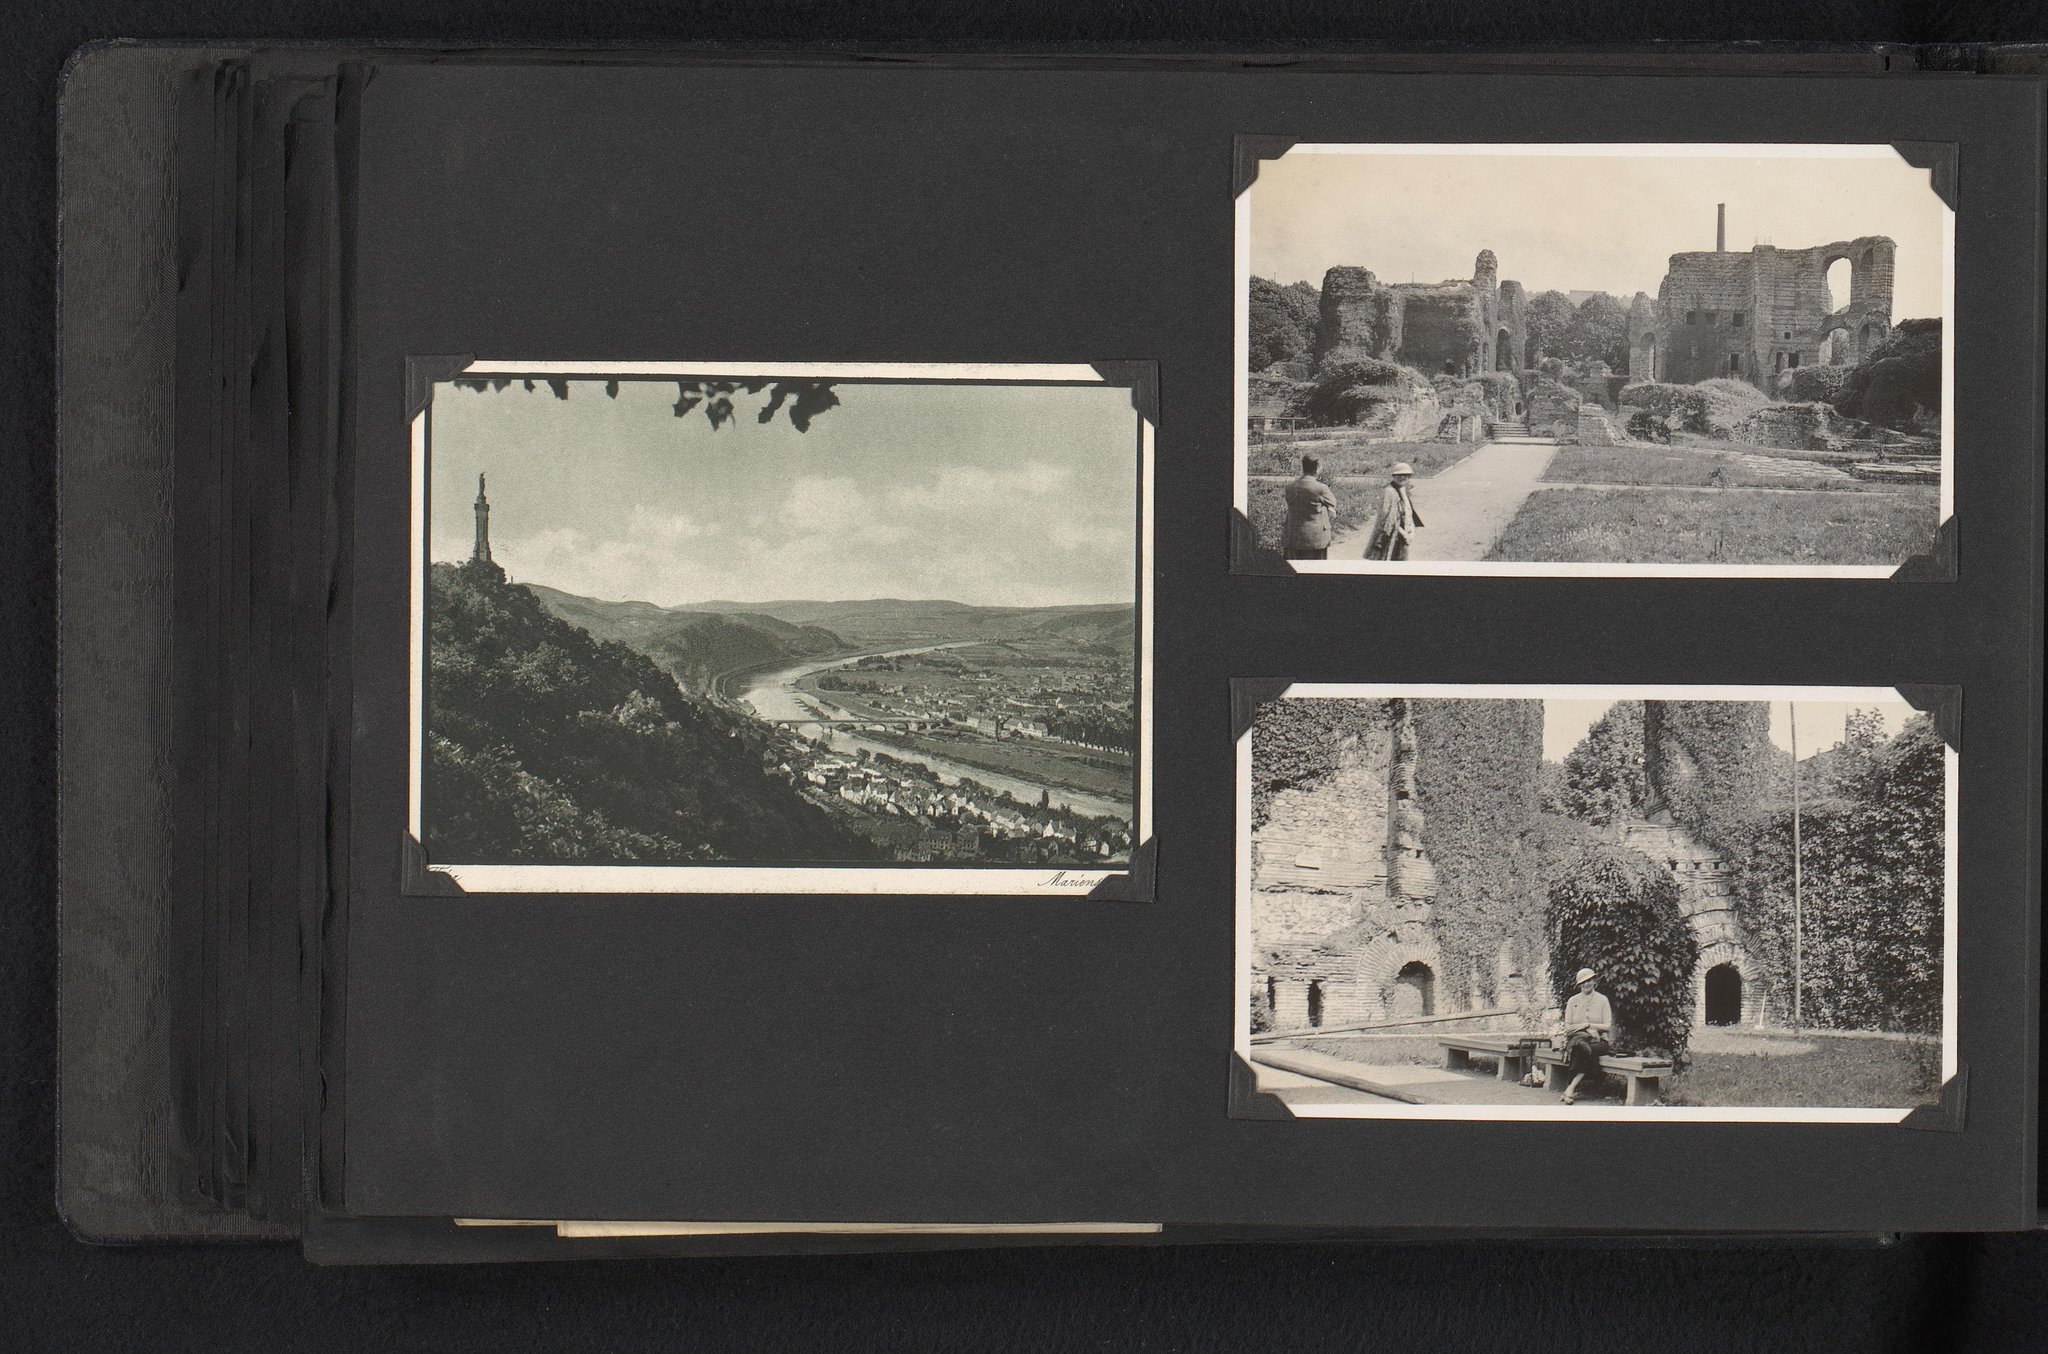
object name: photograph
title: Twee foto's en een fotomechanische prentbriefkaart van Trier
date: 1908-1934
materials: paper, cardboard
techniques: gelatin silver print, rotogravure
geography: trier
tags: the hague, caroline louise van den berg-van den berg, sightseeing, city-view in general; 'veduta', ruin of a building ~ architecture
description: Deze prent en foto's maken deel uit van een album.